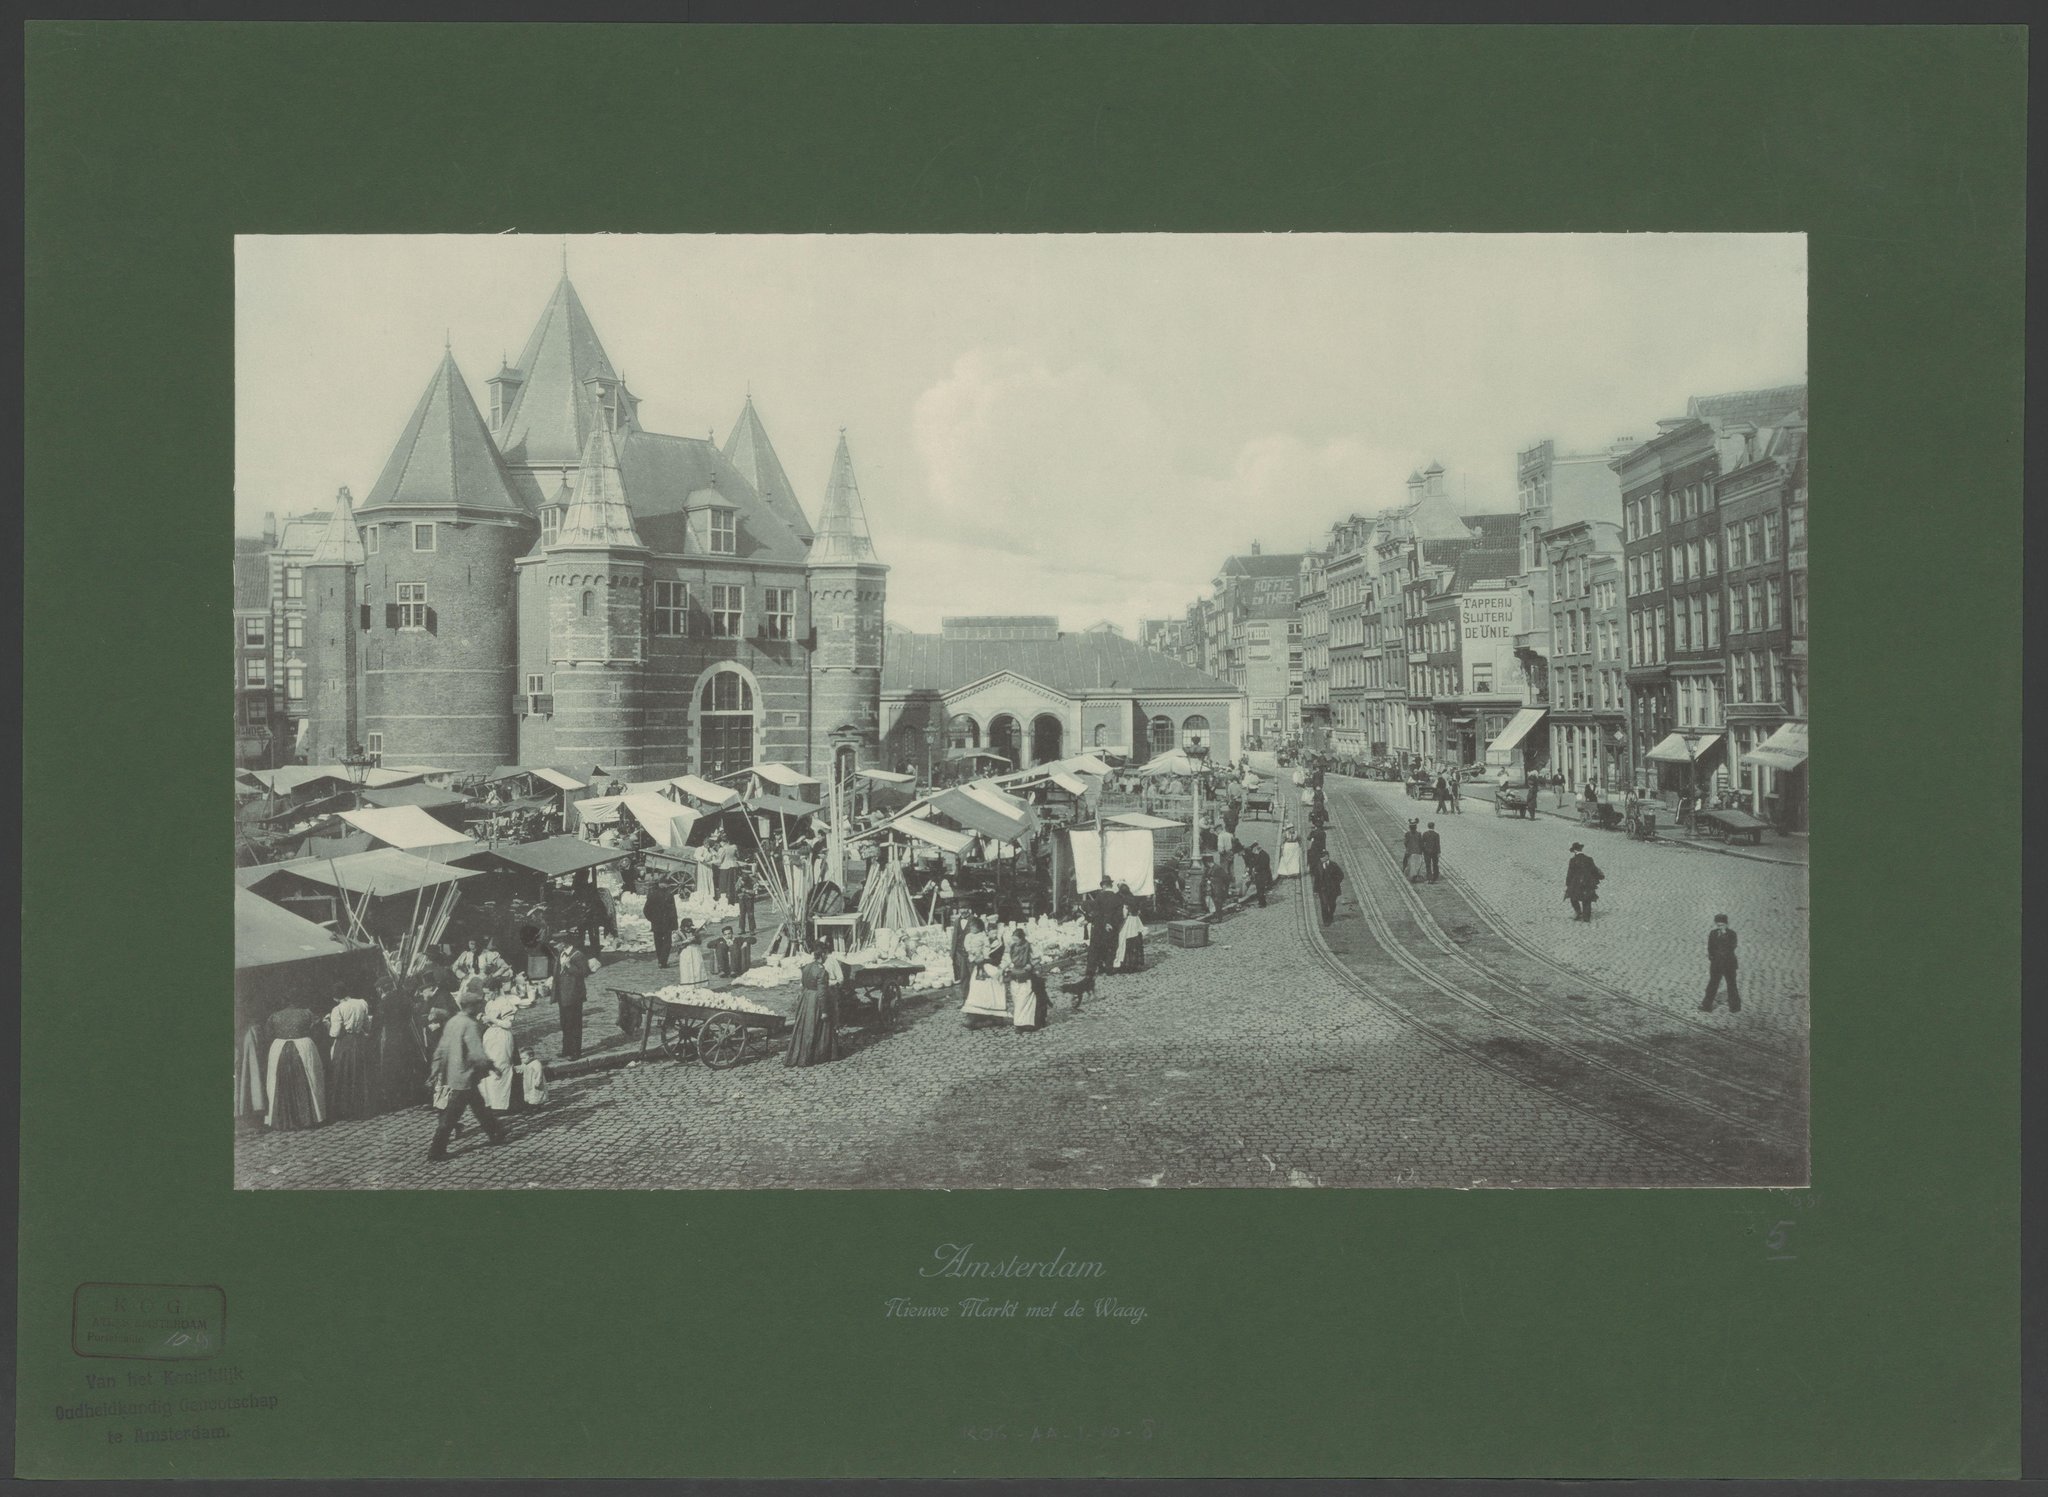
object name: photomechanical print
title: Gezicht op de markt op de Nieuwmarkt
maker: Anonymous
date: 1875-1950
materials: cardboard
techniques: photograph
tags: square, place, circus, etc., tramway, tram, city-view in general; 'veduta', stall, booth (~ market), market, weigh-house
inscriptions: collector's mark: ‘10,81’ Lugt 1641b, inscription: ‘Amsterdam / Nieuwe Markt met de Waag.’, stamp: ‘Van het Koninklijk / Oudheidkundig Genootschap / te Amsterdam.’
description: Onderwerpsrubriek binnen de Atlas Amsterdam: Nieuwmarkt, Noordermarkt.